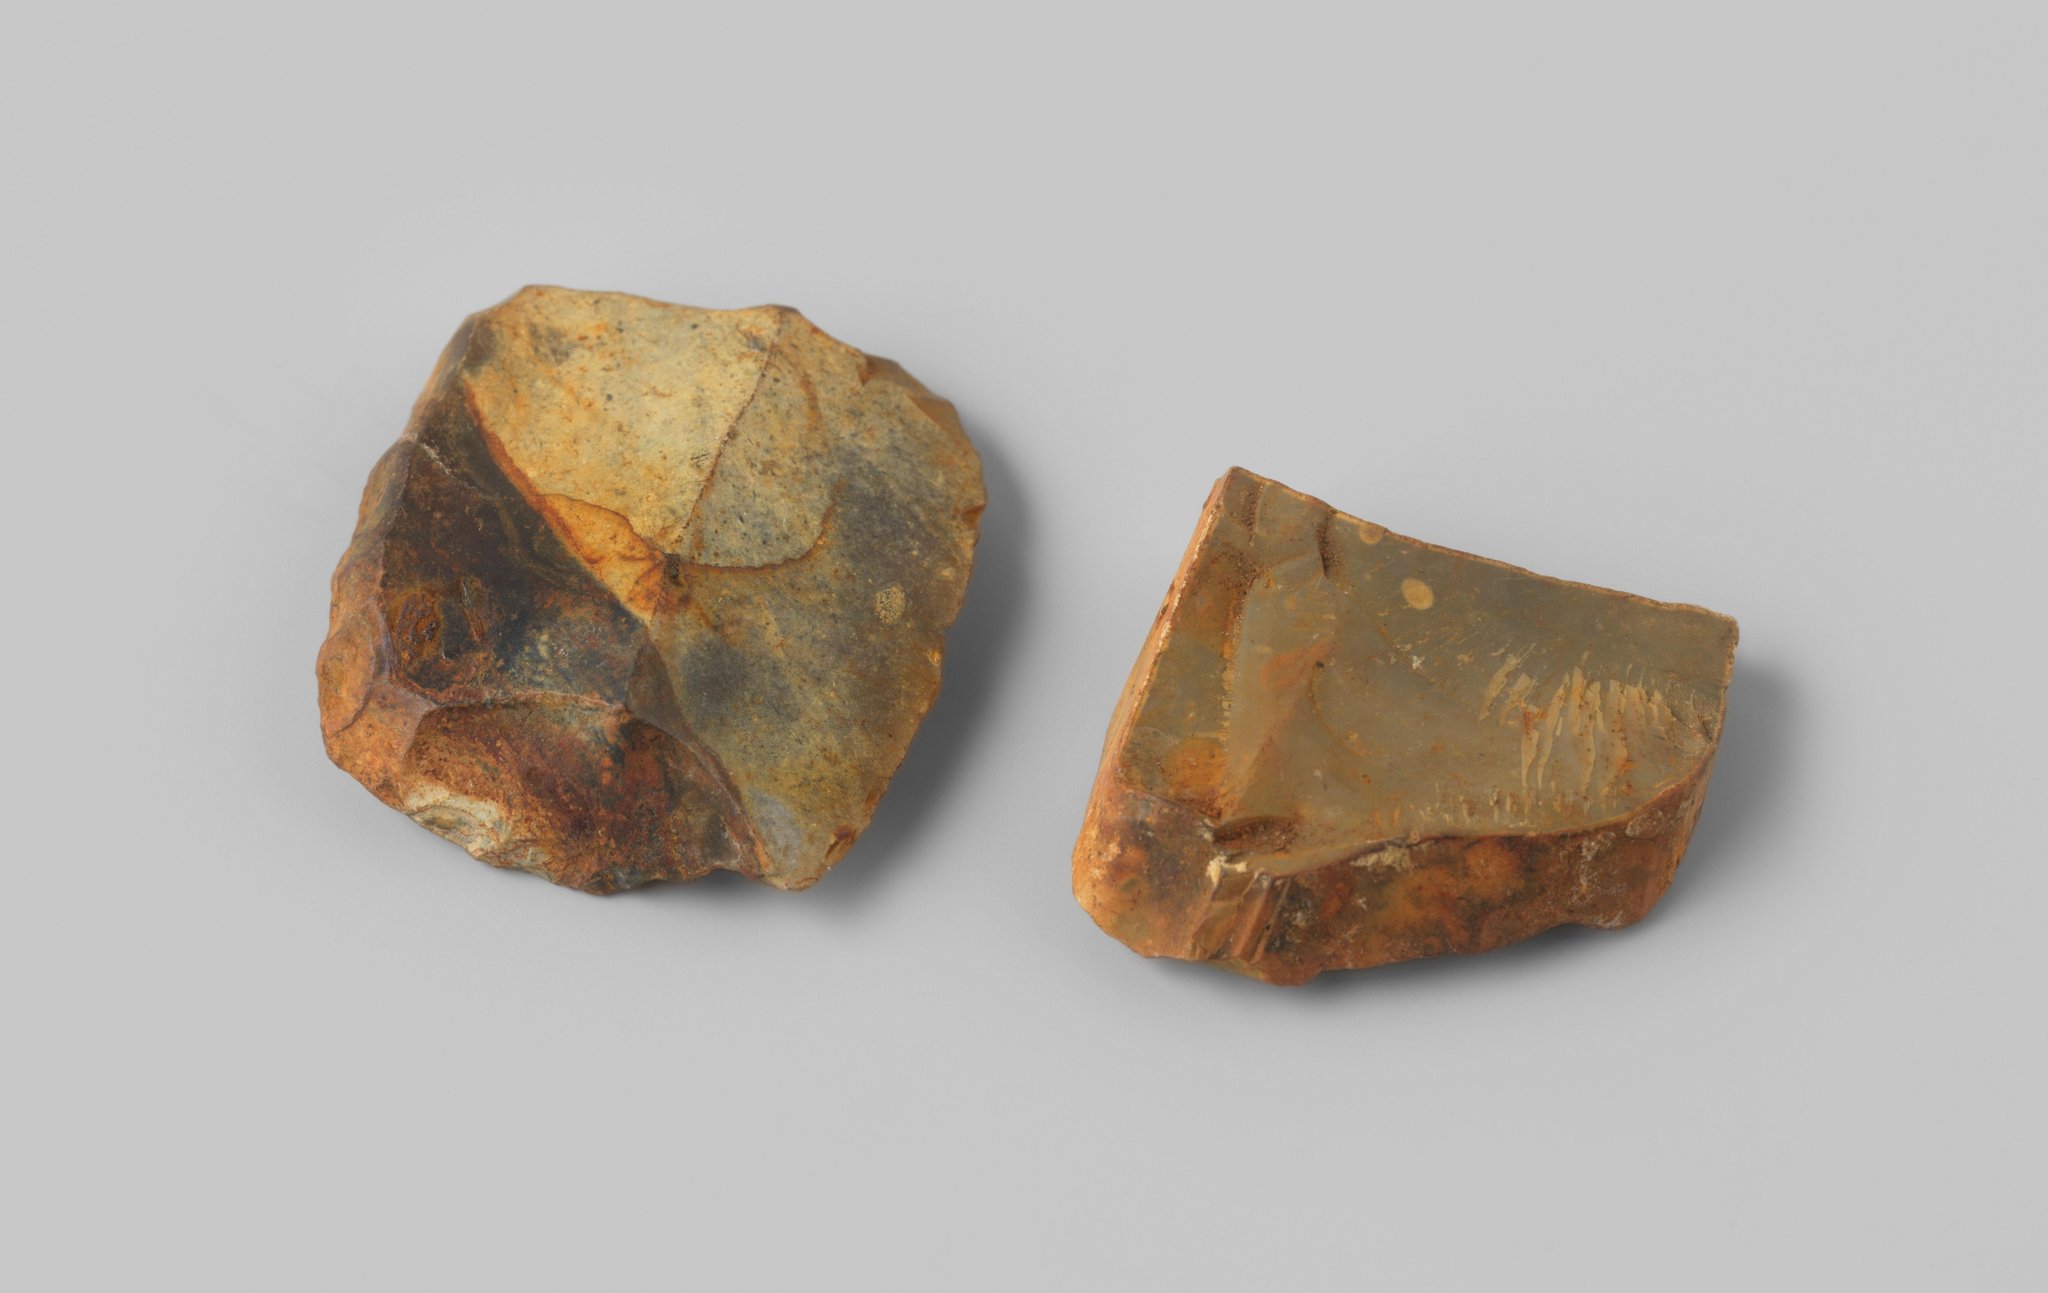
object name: gunflint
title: Vuurstenen van een handwapen uit het wrak van de Oost-Indiëvaarder Hollandia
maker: Anonymous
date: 1700-1743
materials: stone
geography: netherlands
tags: verenigde oostindische compagnie, hollandia (schip), annet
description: Hand weapon, flint; sim. NG 1980-27H3128.